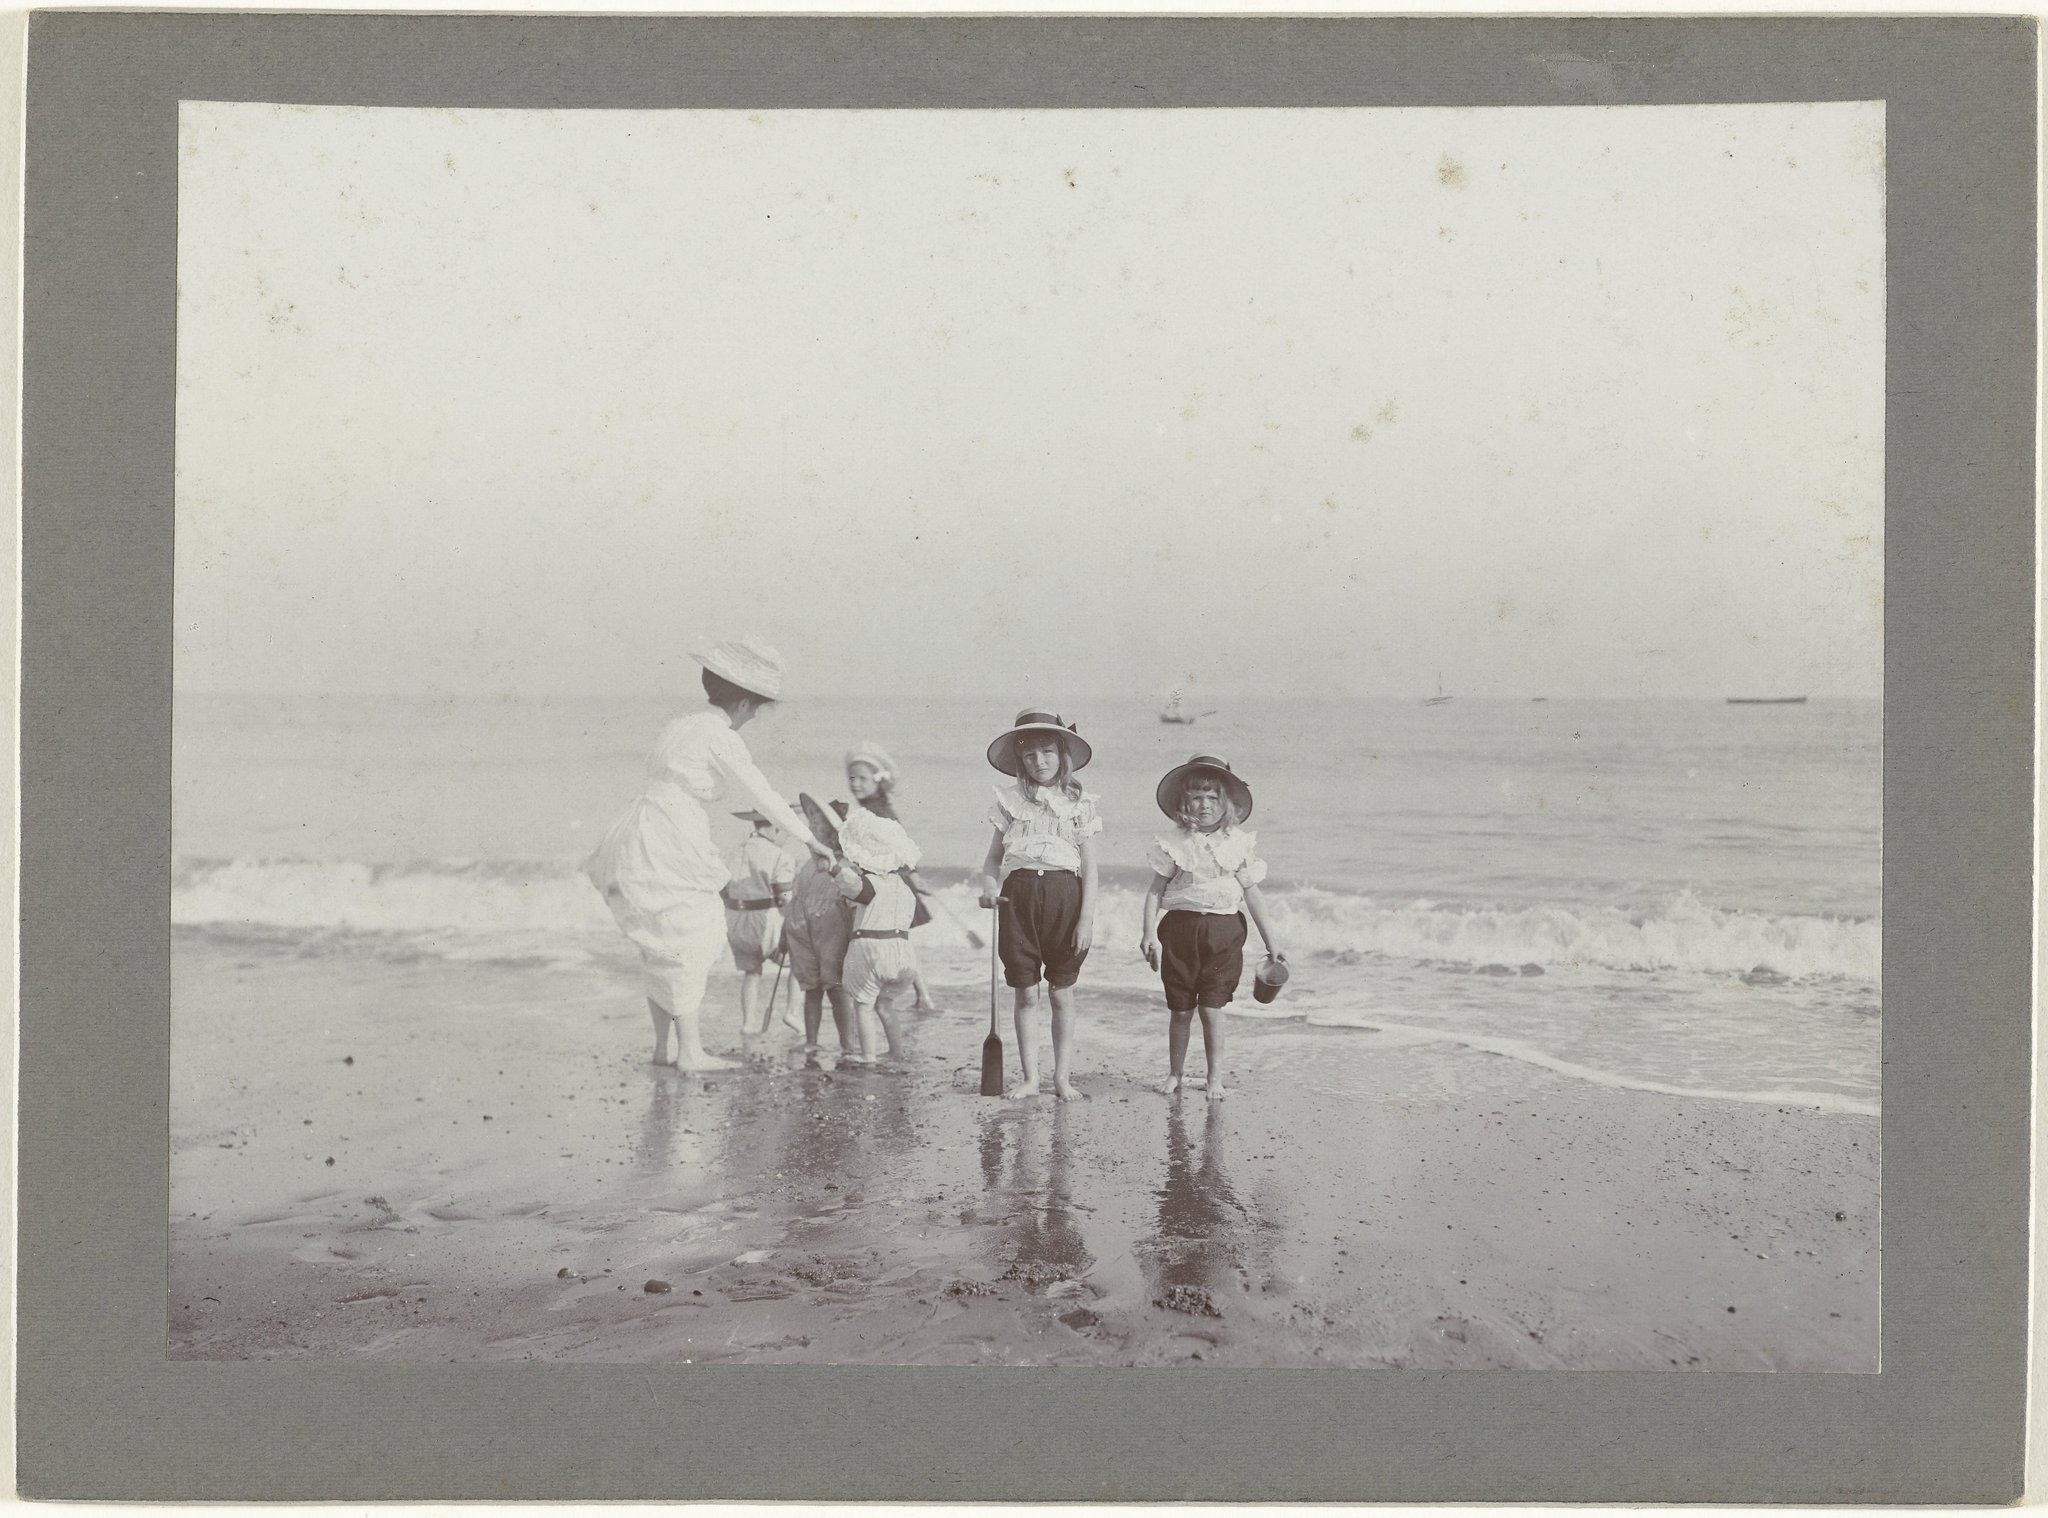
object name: photograph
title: Sacha en Renee Pauw van Wieldrecht met andere kinderen en een vrouw op het strand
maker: henry pauw van wieldrecht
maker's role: fotograaf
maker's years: 1863-1912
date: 1909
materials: cardboard, photographic support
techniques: collodion silver print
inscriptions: annotation: ‘No 3569. / 1909.’, annotation: ‘Sacha + Renée’